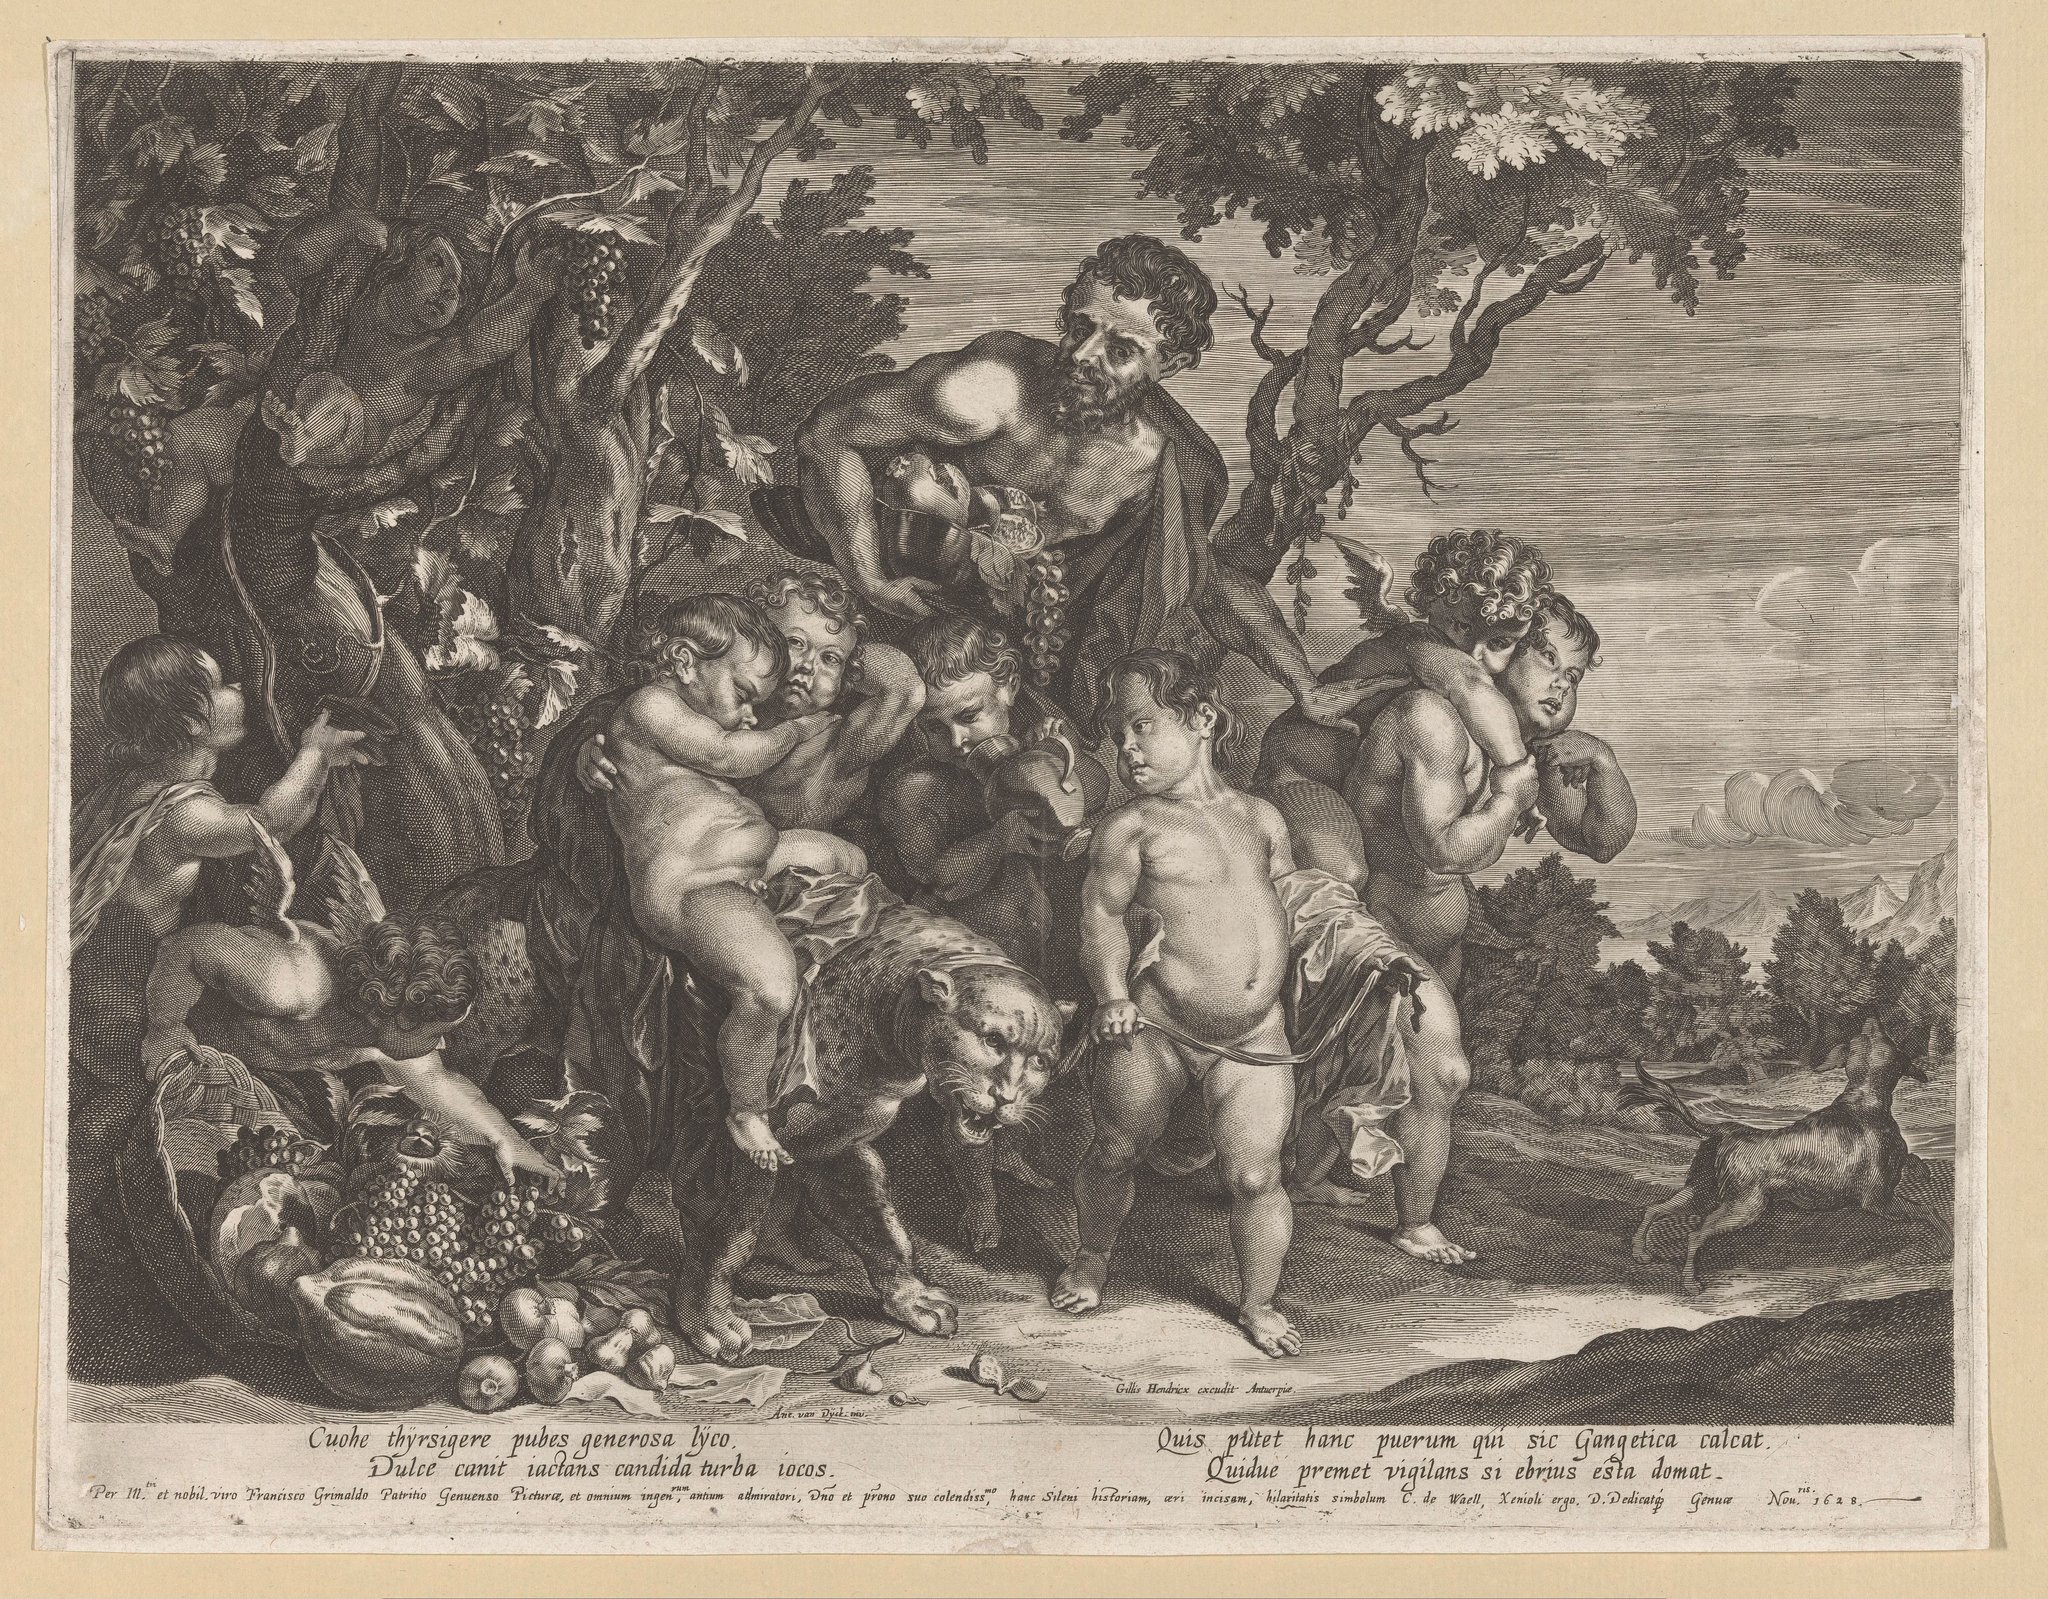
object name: print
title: Triomf van Bacchus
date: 1611-1628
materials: paper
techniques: engraving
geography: genoa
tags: beasts of prey, predatory animals: leopard, triumph of bacchus; 'carro di bacco' (ripa)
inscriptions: collector's mark: Lugt 240